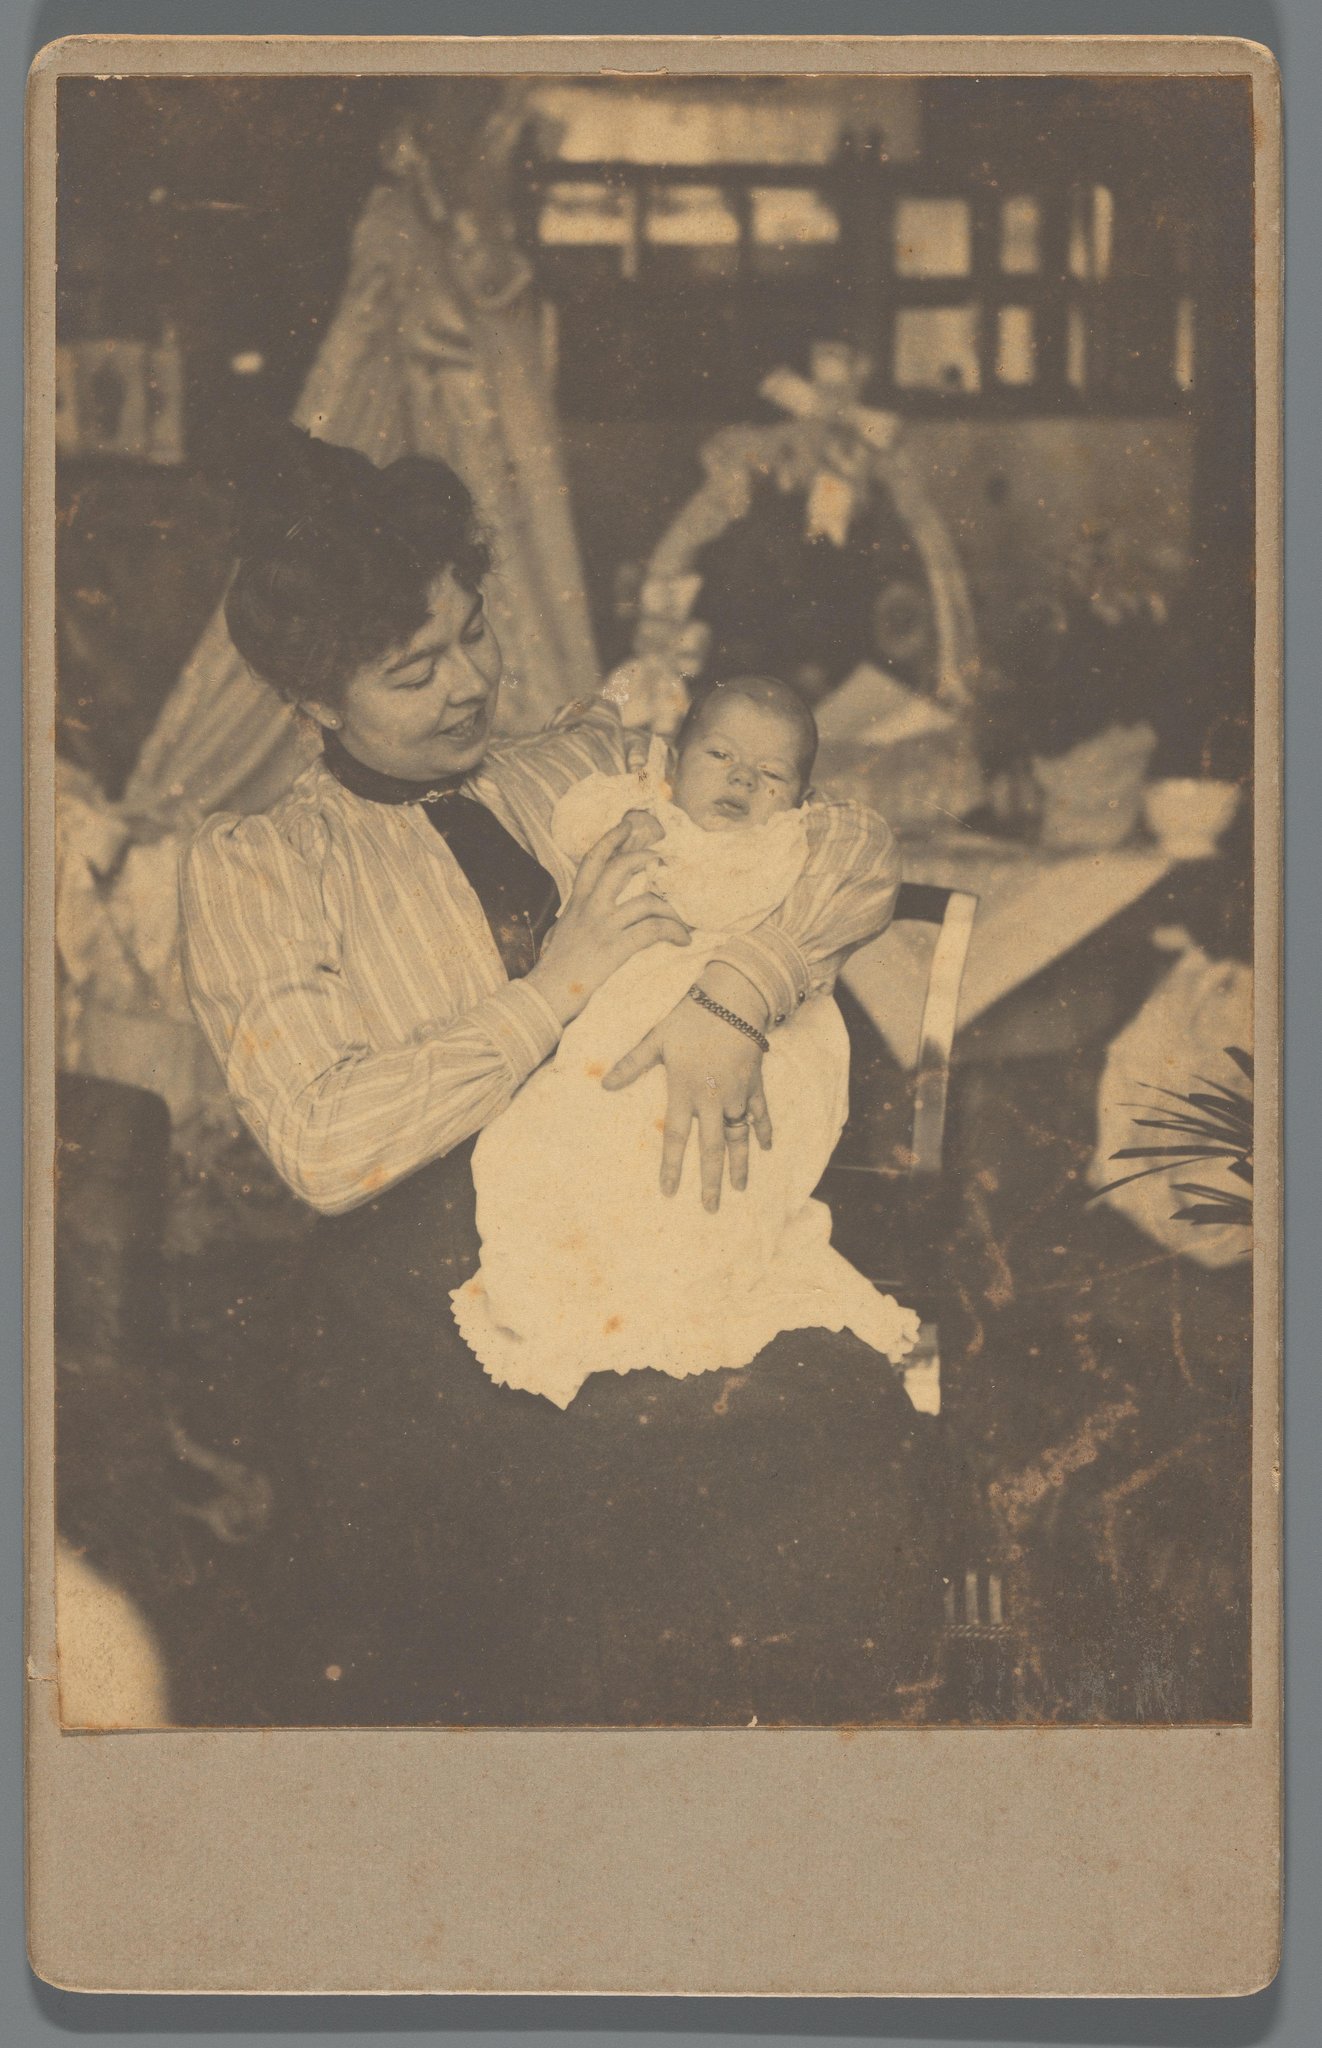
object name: cabinet photograph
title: Portret van A.C.M. Geertsema met een baby in haar armen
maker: Anonymous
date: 1900-1920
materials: cardboard, photographic support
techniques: albumen print